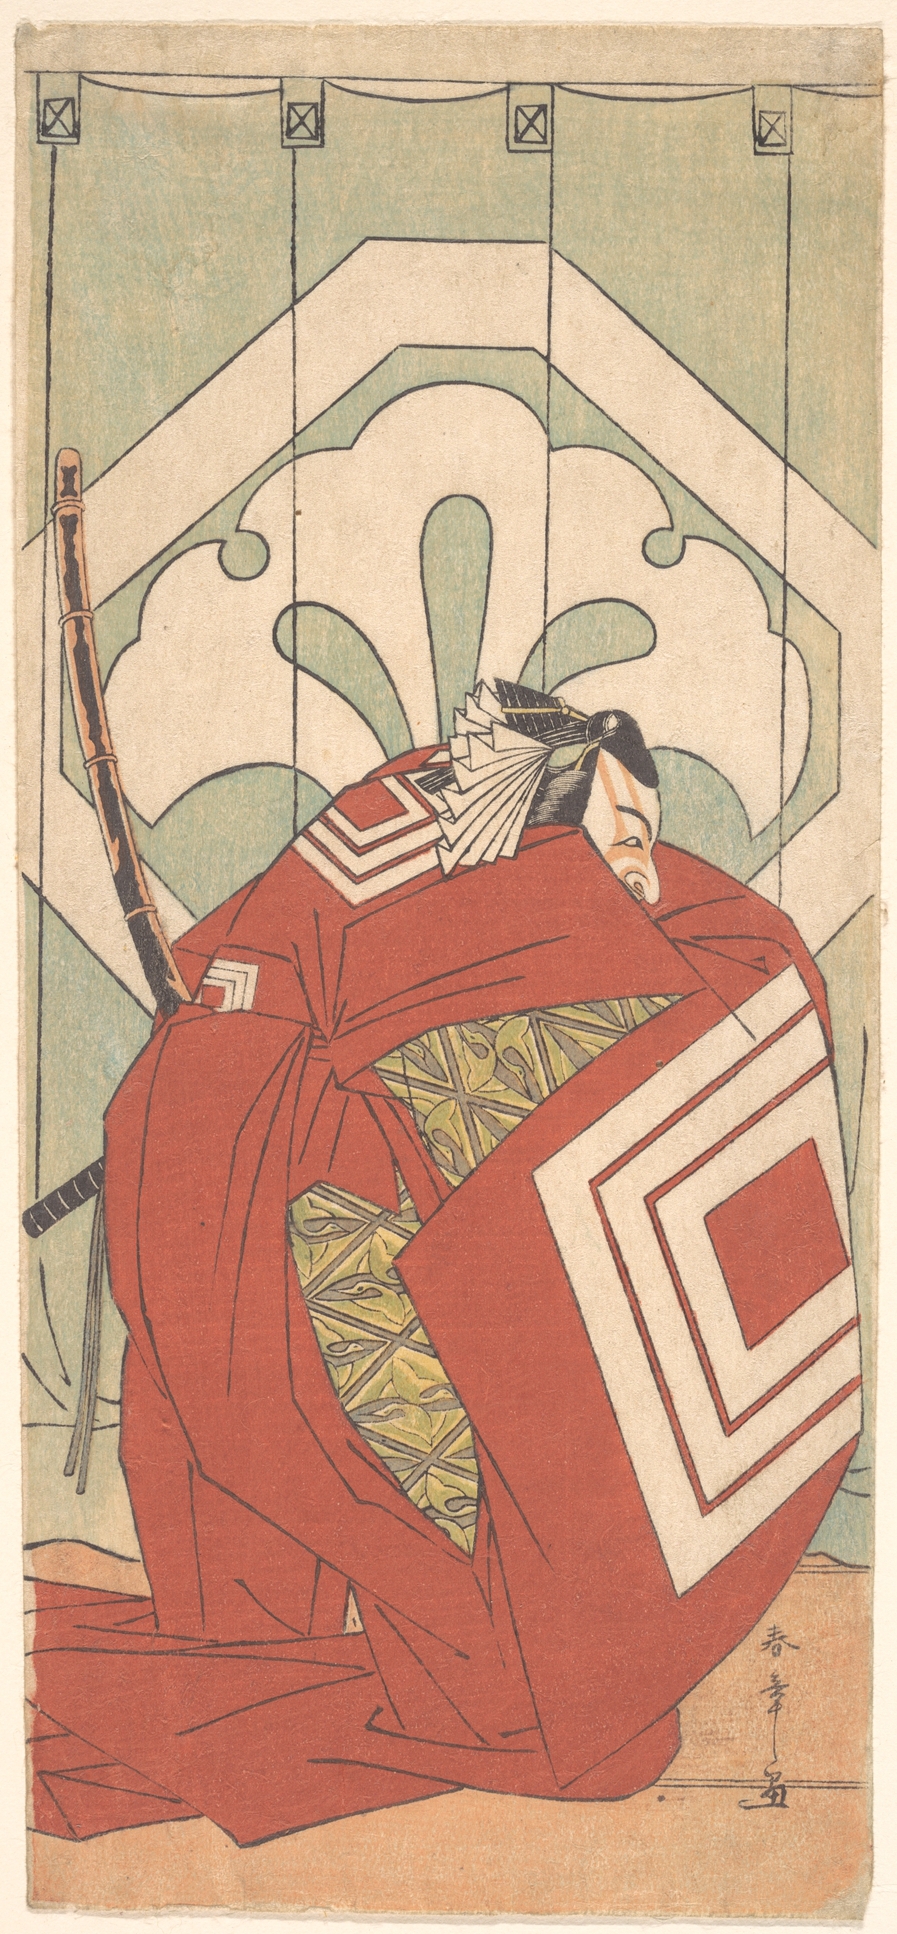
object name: woodblock print nishiki e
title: Ichikawa Danjuro V in a Shibaraku Role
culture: japanese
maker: katsukawa shunshō 勝川春章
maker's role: artist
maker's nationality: japanese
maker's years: 1726-1792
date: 1779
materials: ink, paper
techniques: nishiki e, woodblock print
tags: men,actors